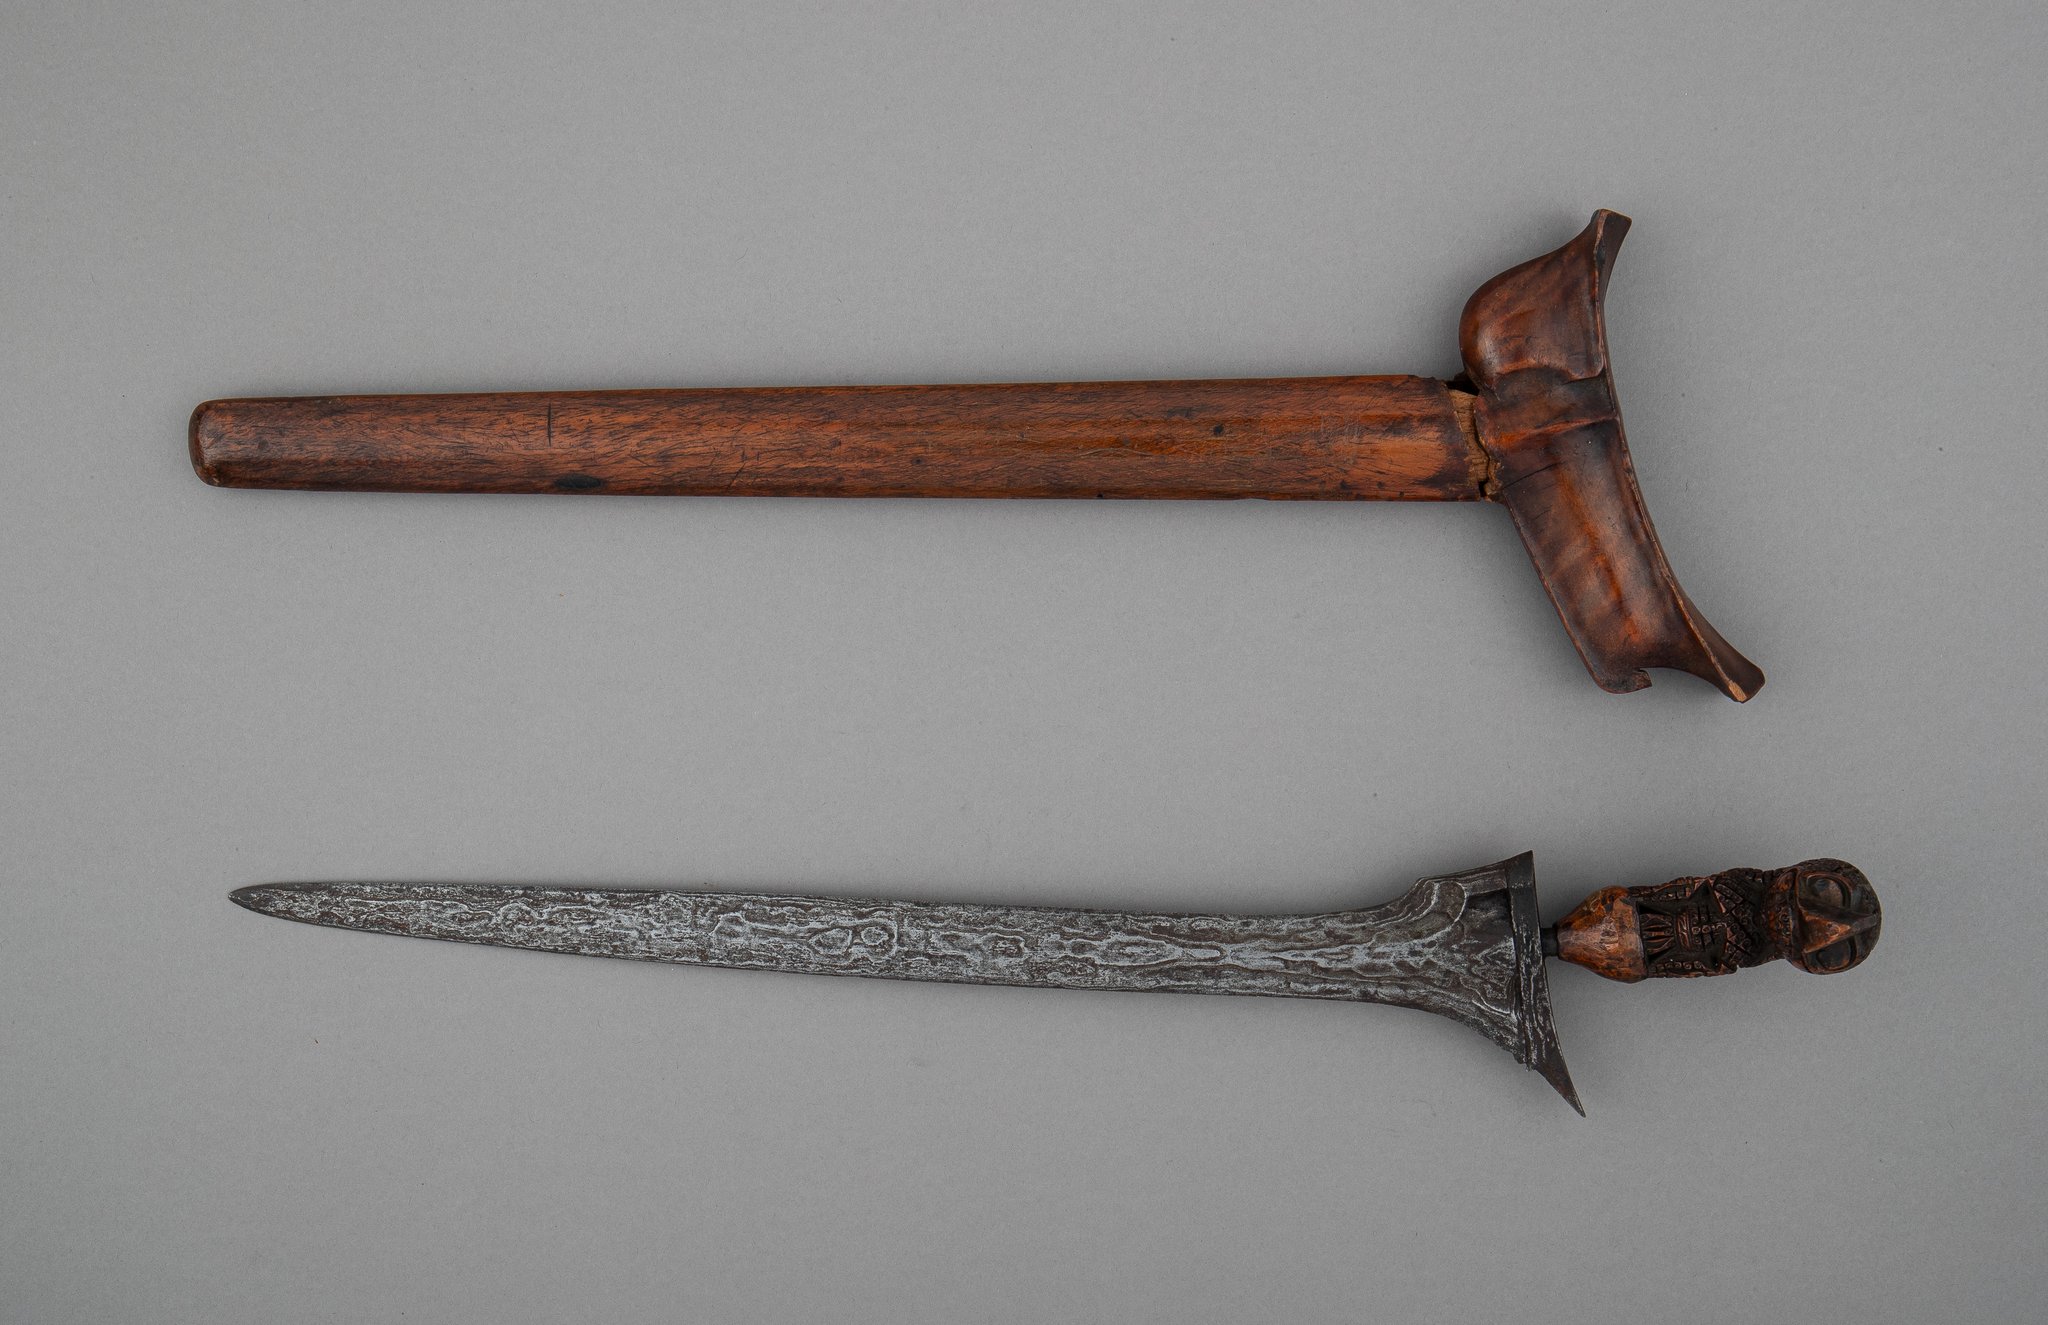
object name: kris with sheath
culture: sumatran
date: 1501-1900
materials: steel, wood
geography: indonesia